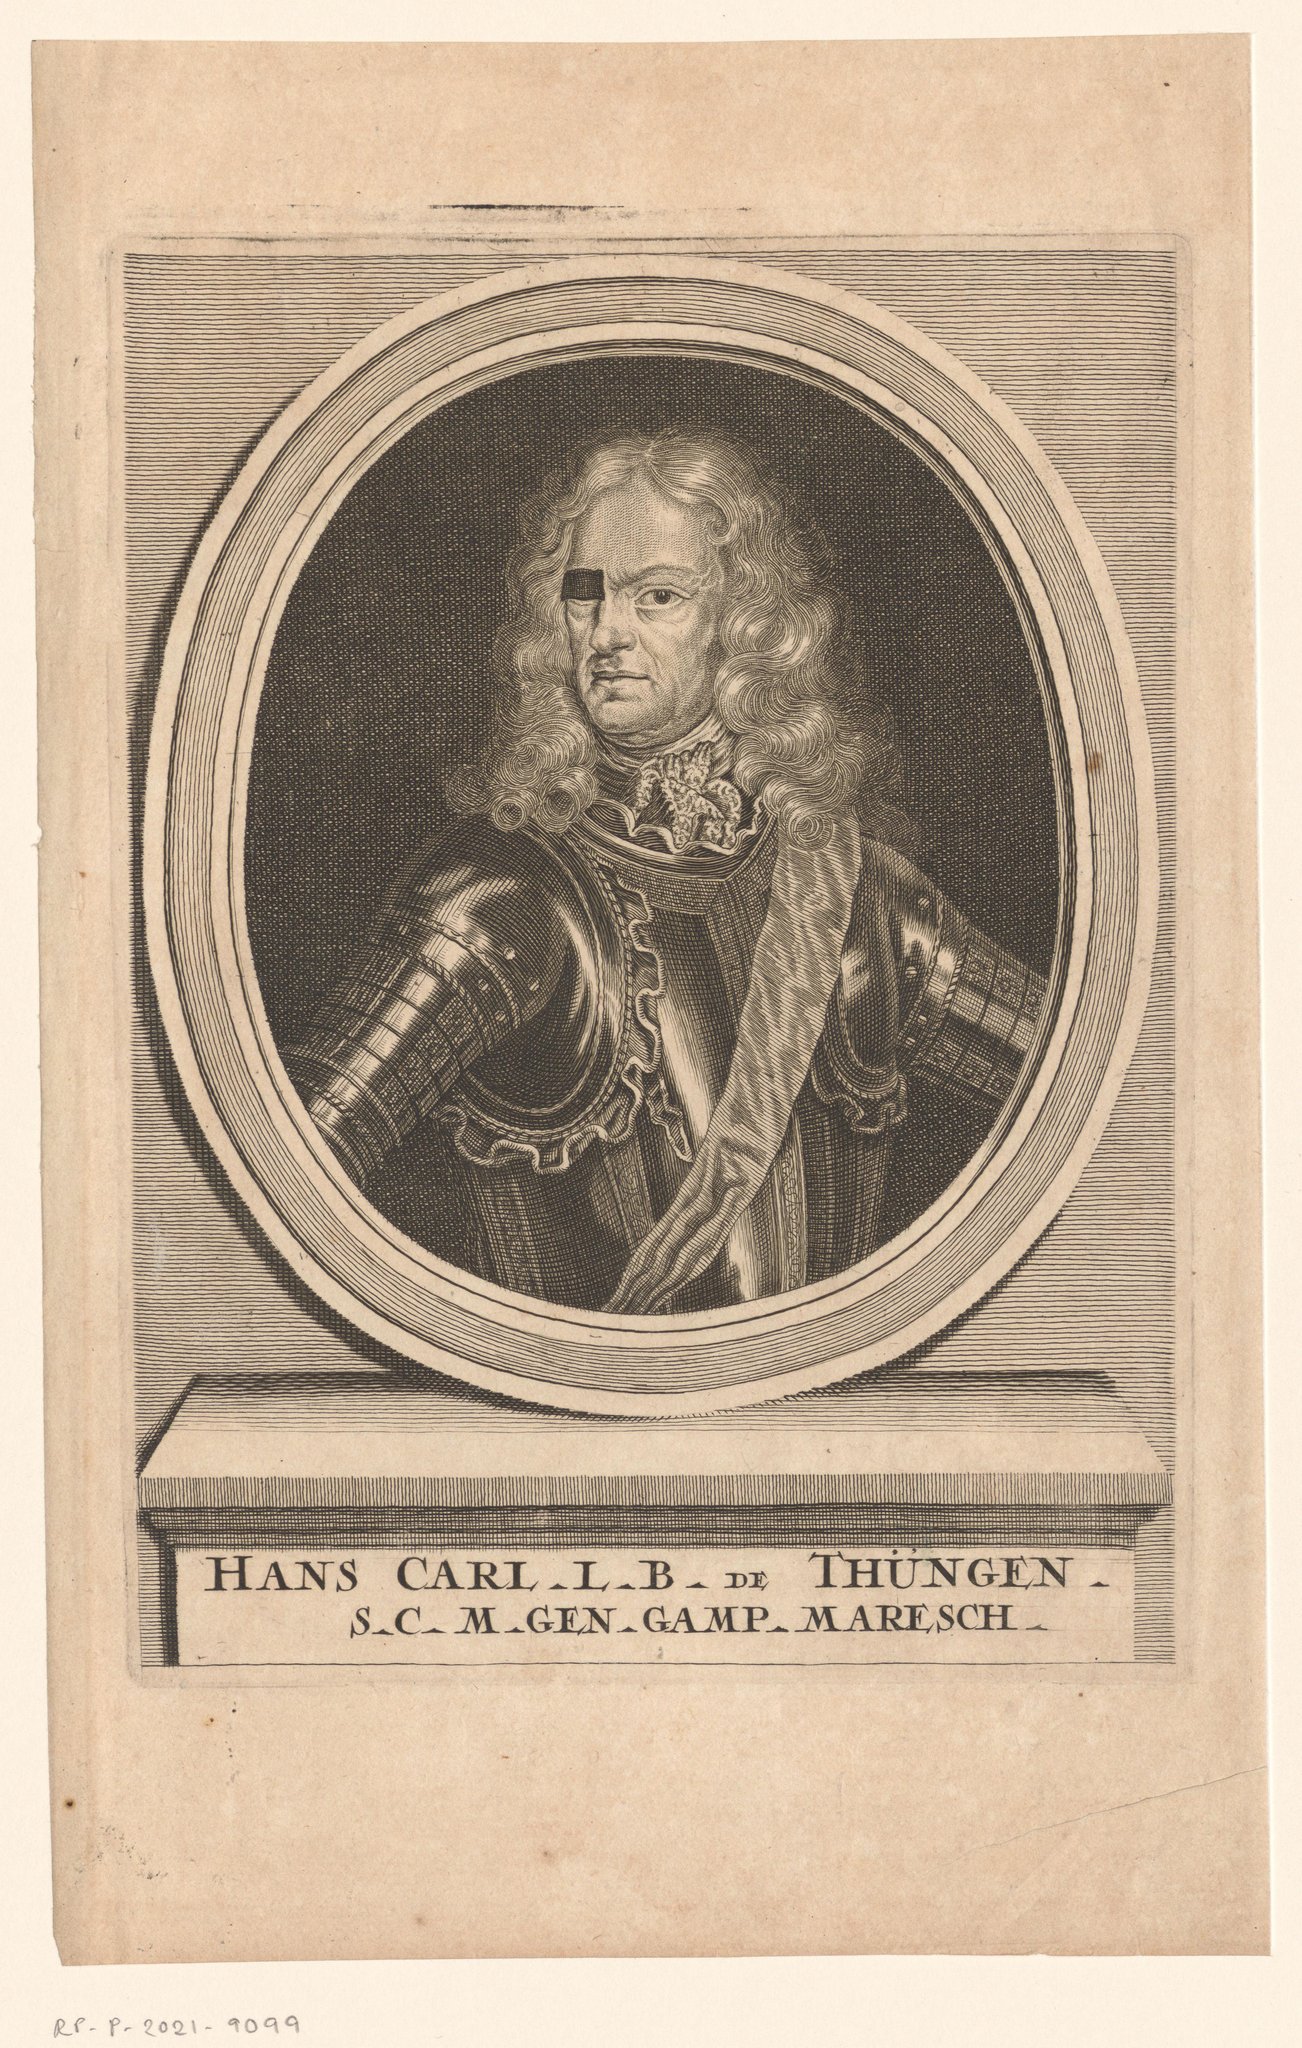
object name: book illustration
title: Portret van Johann Carl von Thüngen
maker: elias nessenthaler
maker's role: print maker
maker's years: 1664-1714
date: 1717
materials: paper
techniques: engraving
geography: frankfurt am main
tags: commander-in-chief, general, marshal, armour, historical persons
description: Prent uit: Theatrum Europaeum. Frankfurt am Main: erven Carl Gustav Merian, 1717, dl. 15.